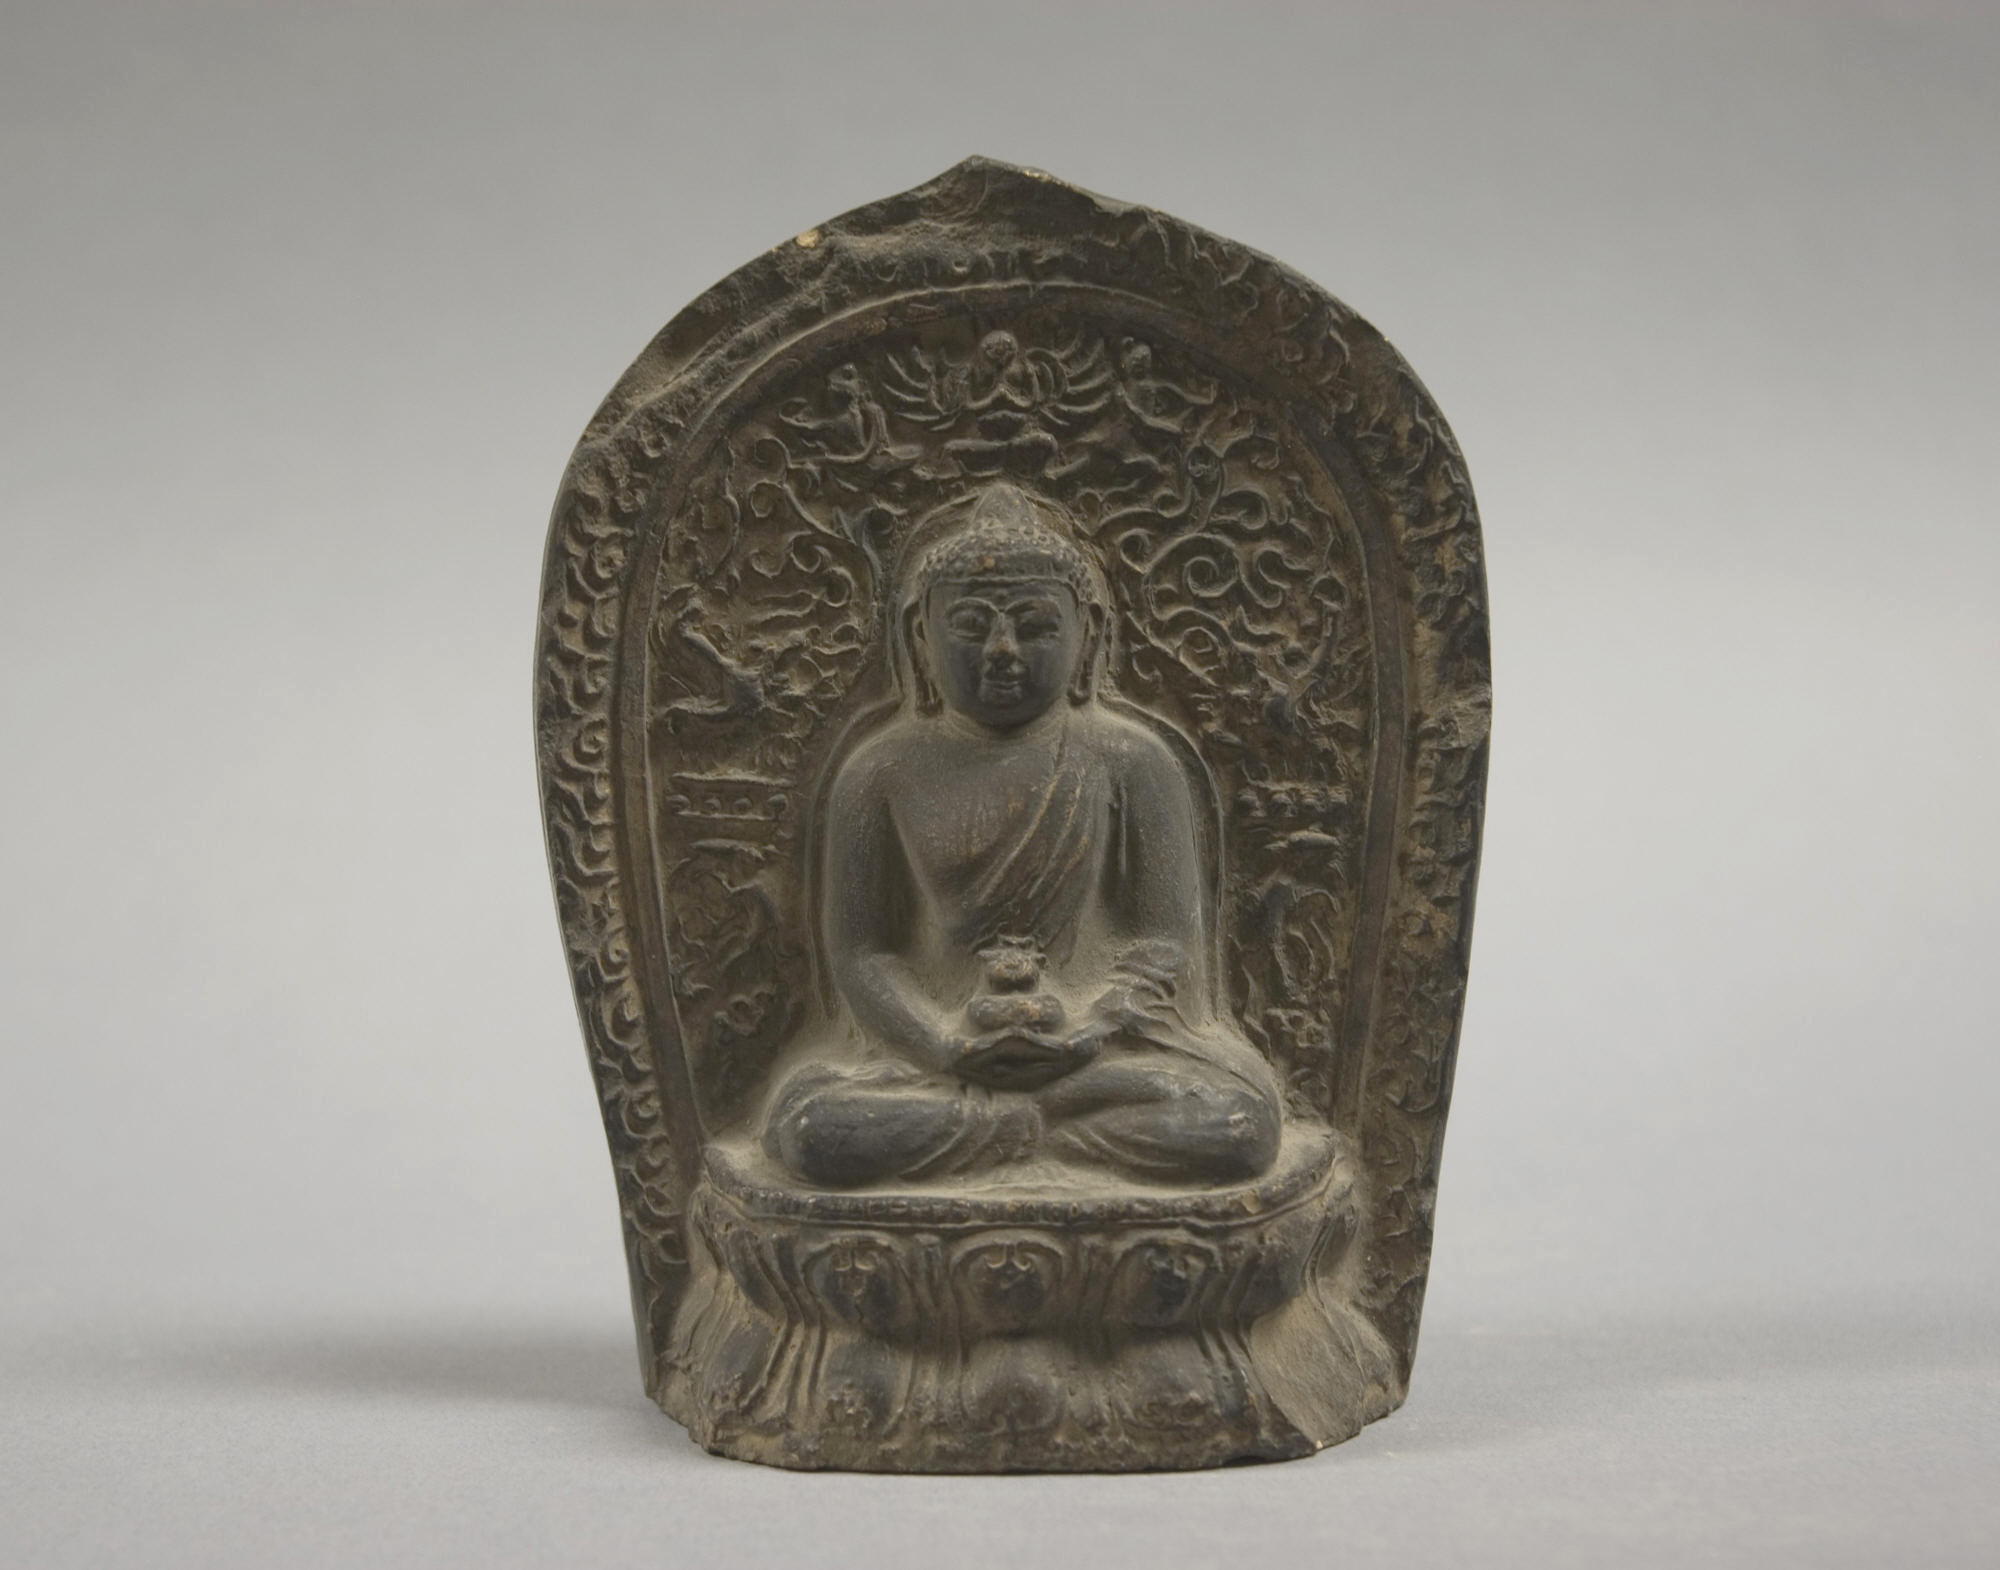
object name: figurine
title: Seated Buddha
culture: tibetan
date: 1501-1900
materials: pottery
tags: buddhism,buddha